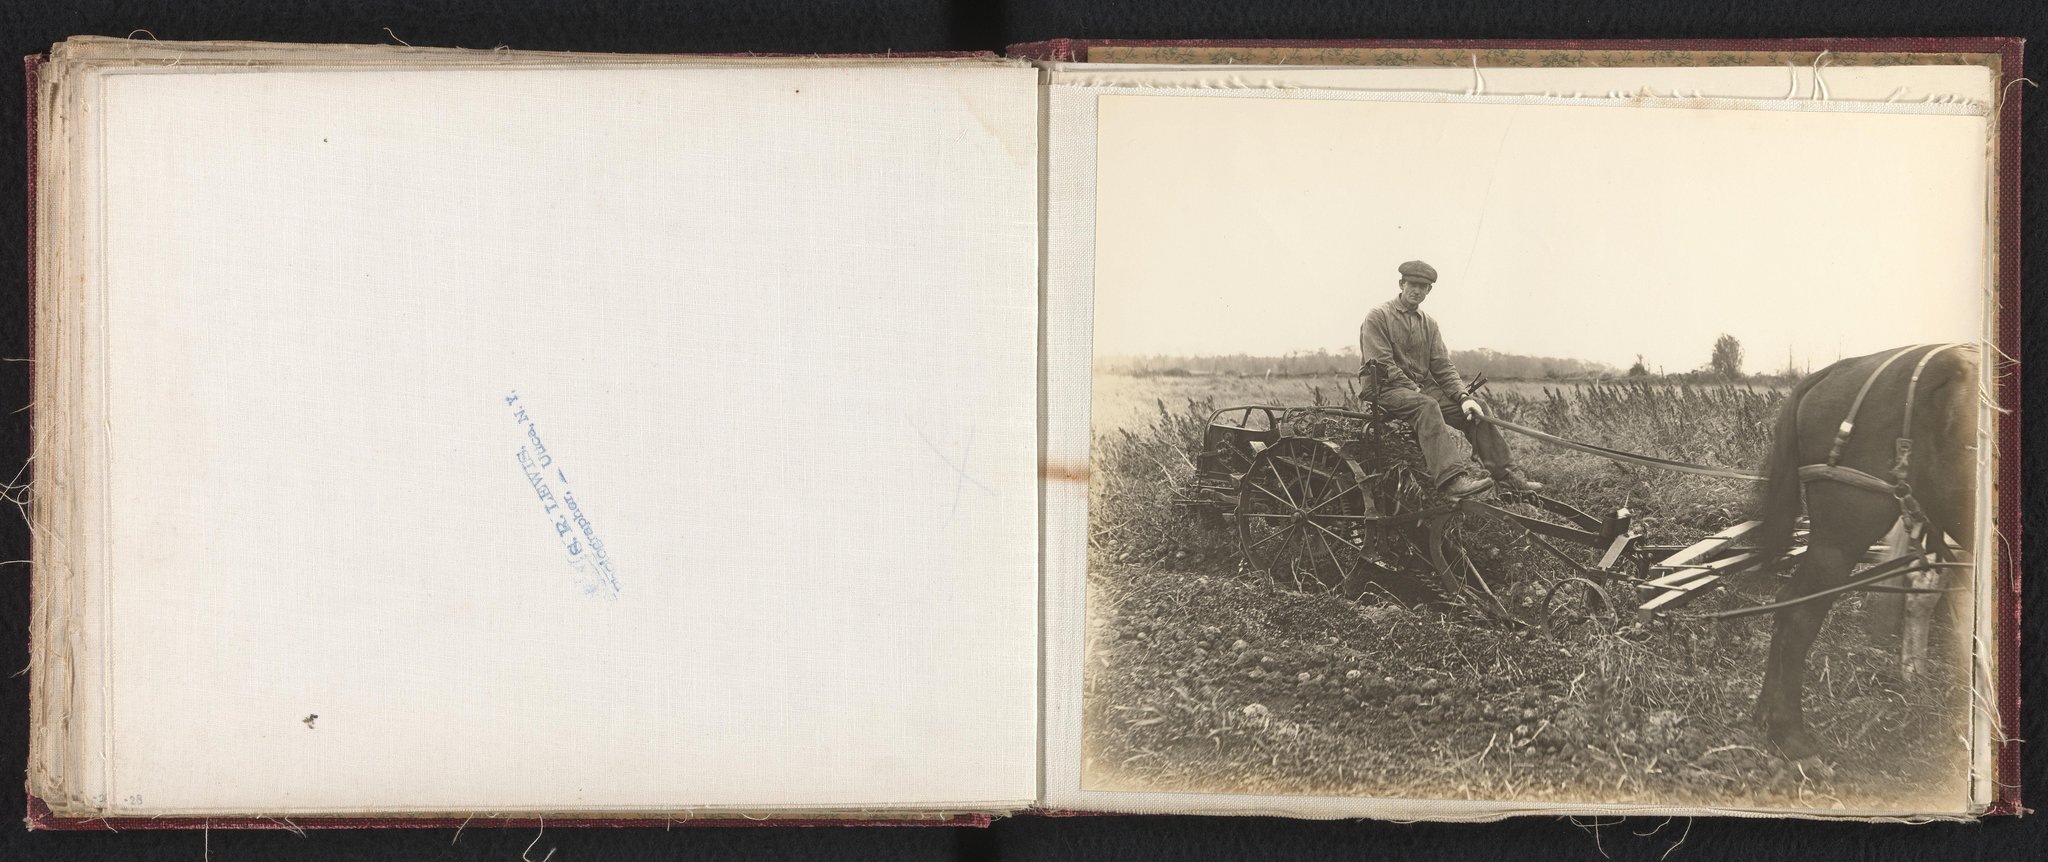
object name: photograph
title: Boer en paard met een landbouwwerktuig van de Eureka Mower Co. te Utrica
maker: lewis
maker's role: fotograaf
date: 1915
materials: paper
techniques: gelatin silver print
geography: utica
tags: agricultural implements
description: Foto op 26e ongenummerde pagina na voorplat.